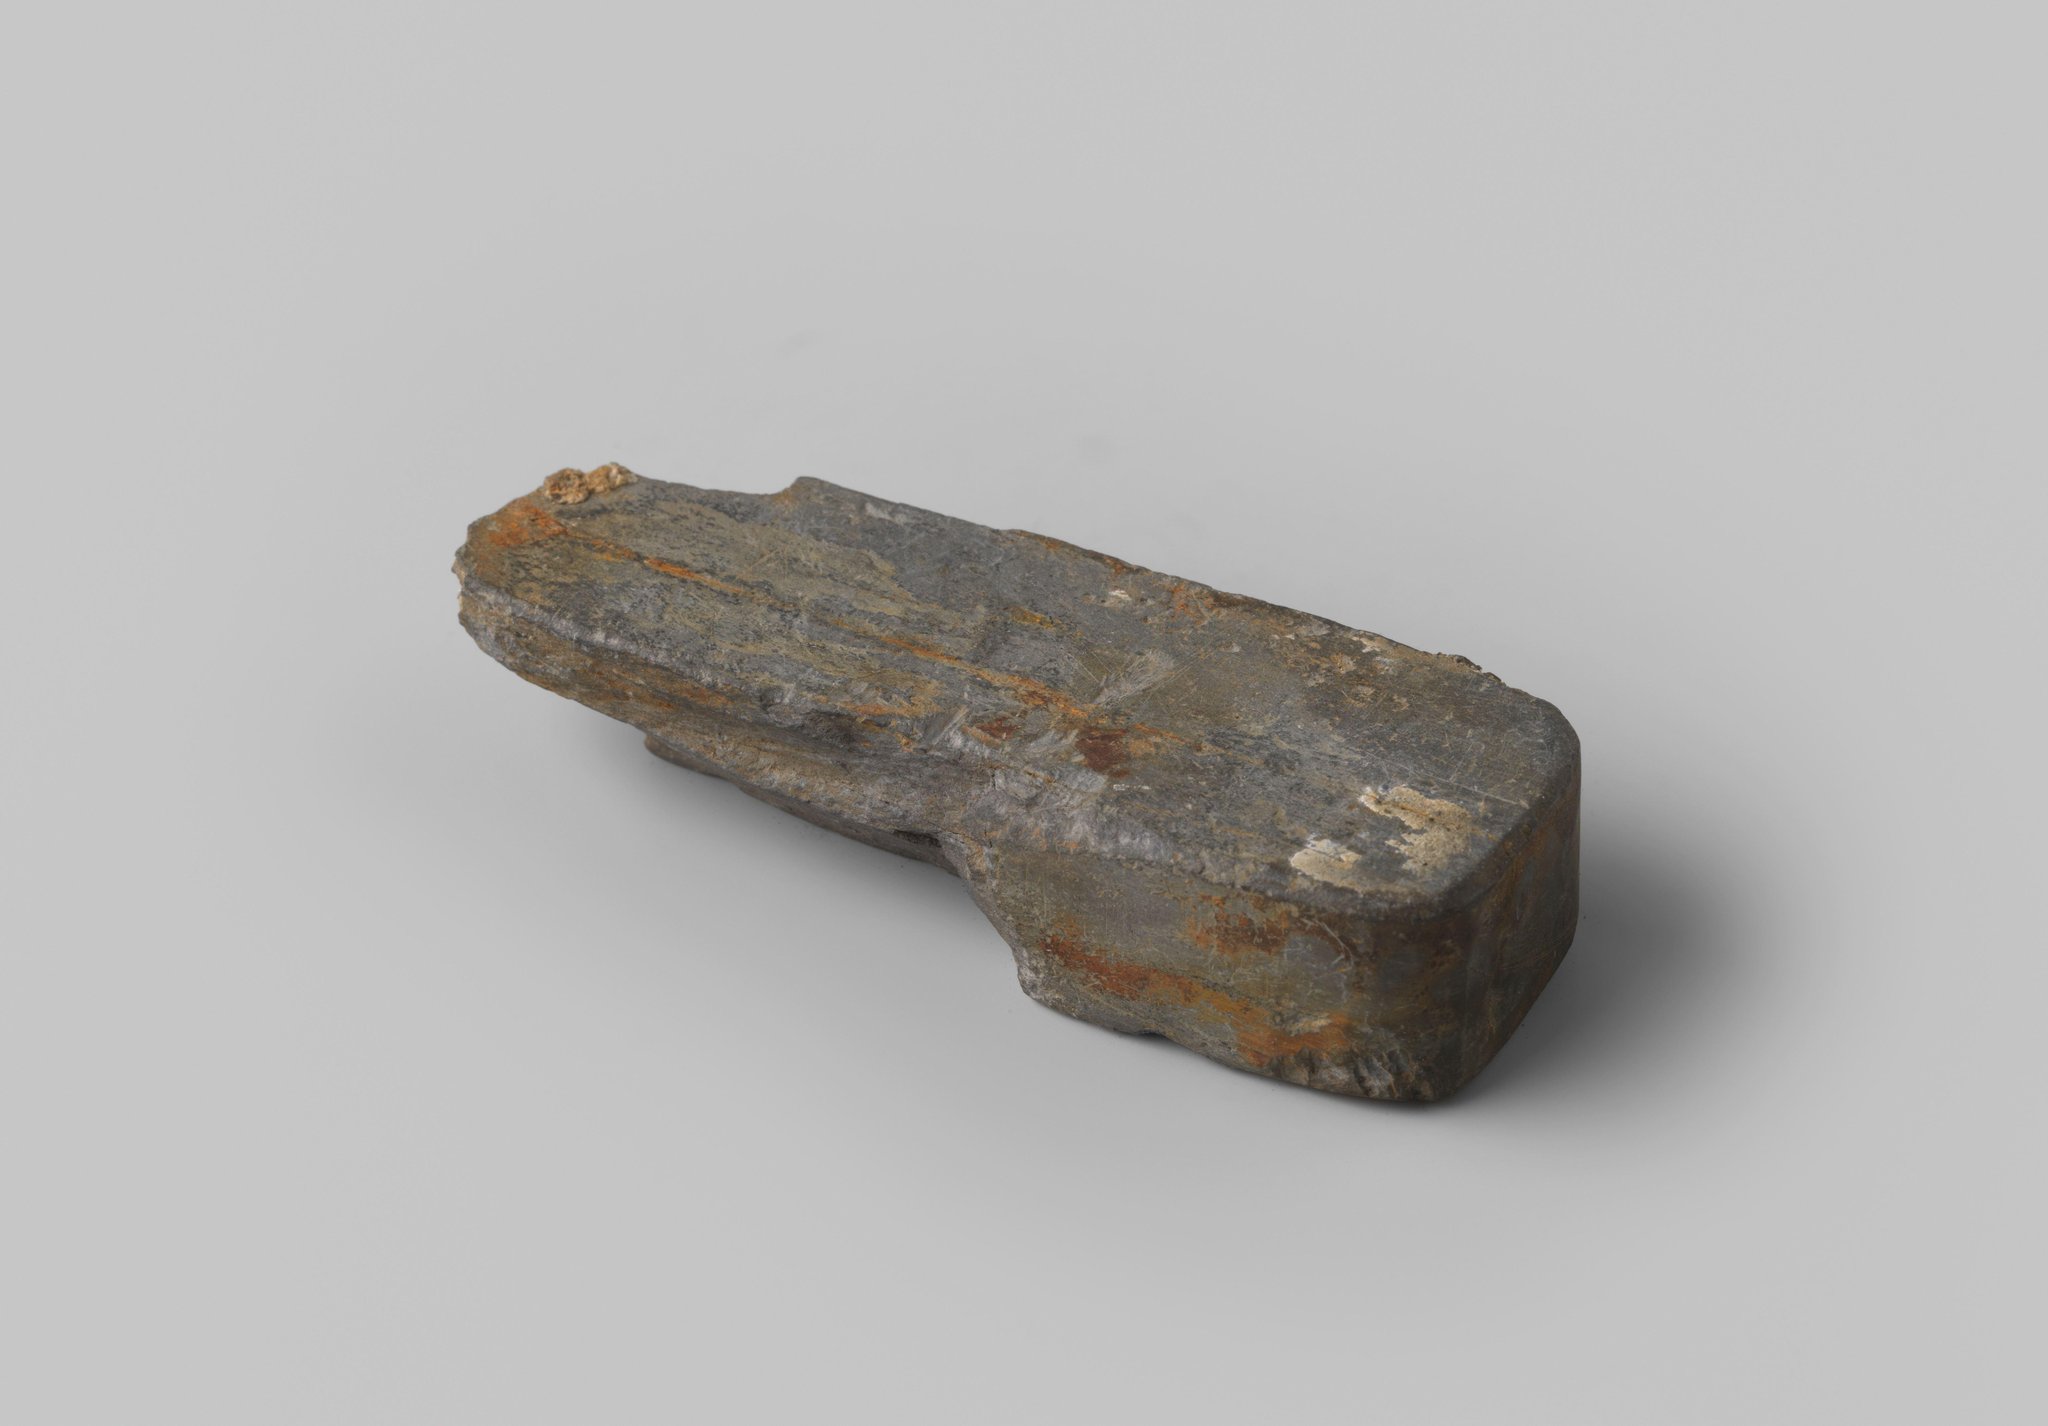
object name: steen objectnaam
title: Bewerkte steen uit het wrak van de Oost-Indiëvaarder Hollandia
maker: Anonymous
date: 1700-1743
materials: stone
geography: netherlands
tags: verenigde oostindische compagnie, hollandia (schip), annet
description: Hone, fragm, one end broken: straight end, rectangular in section.